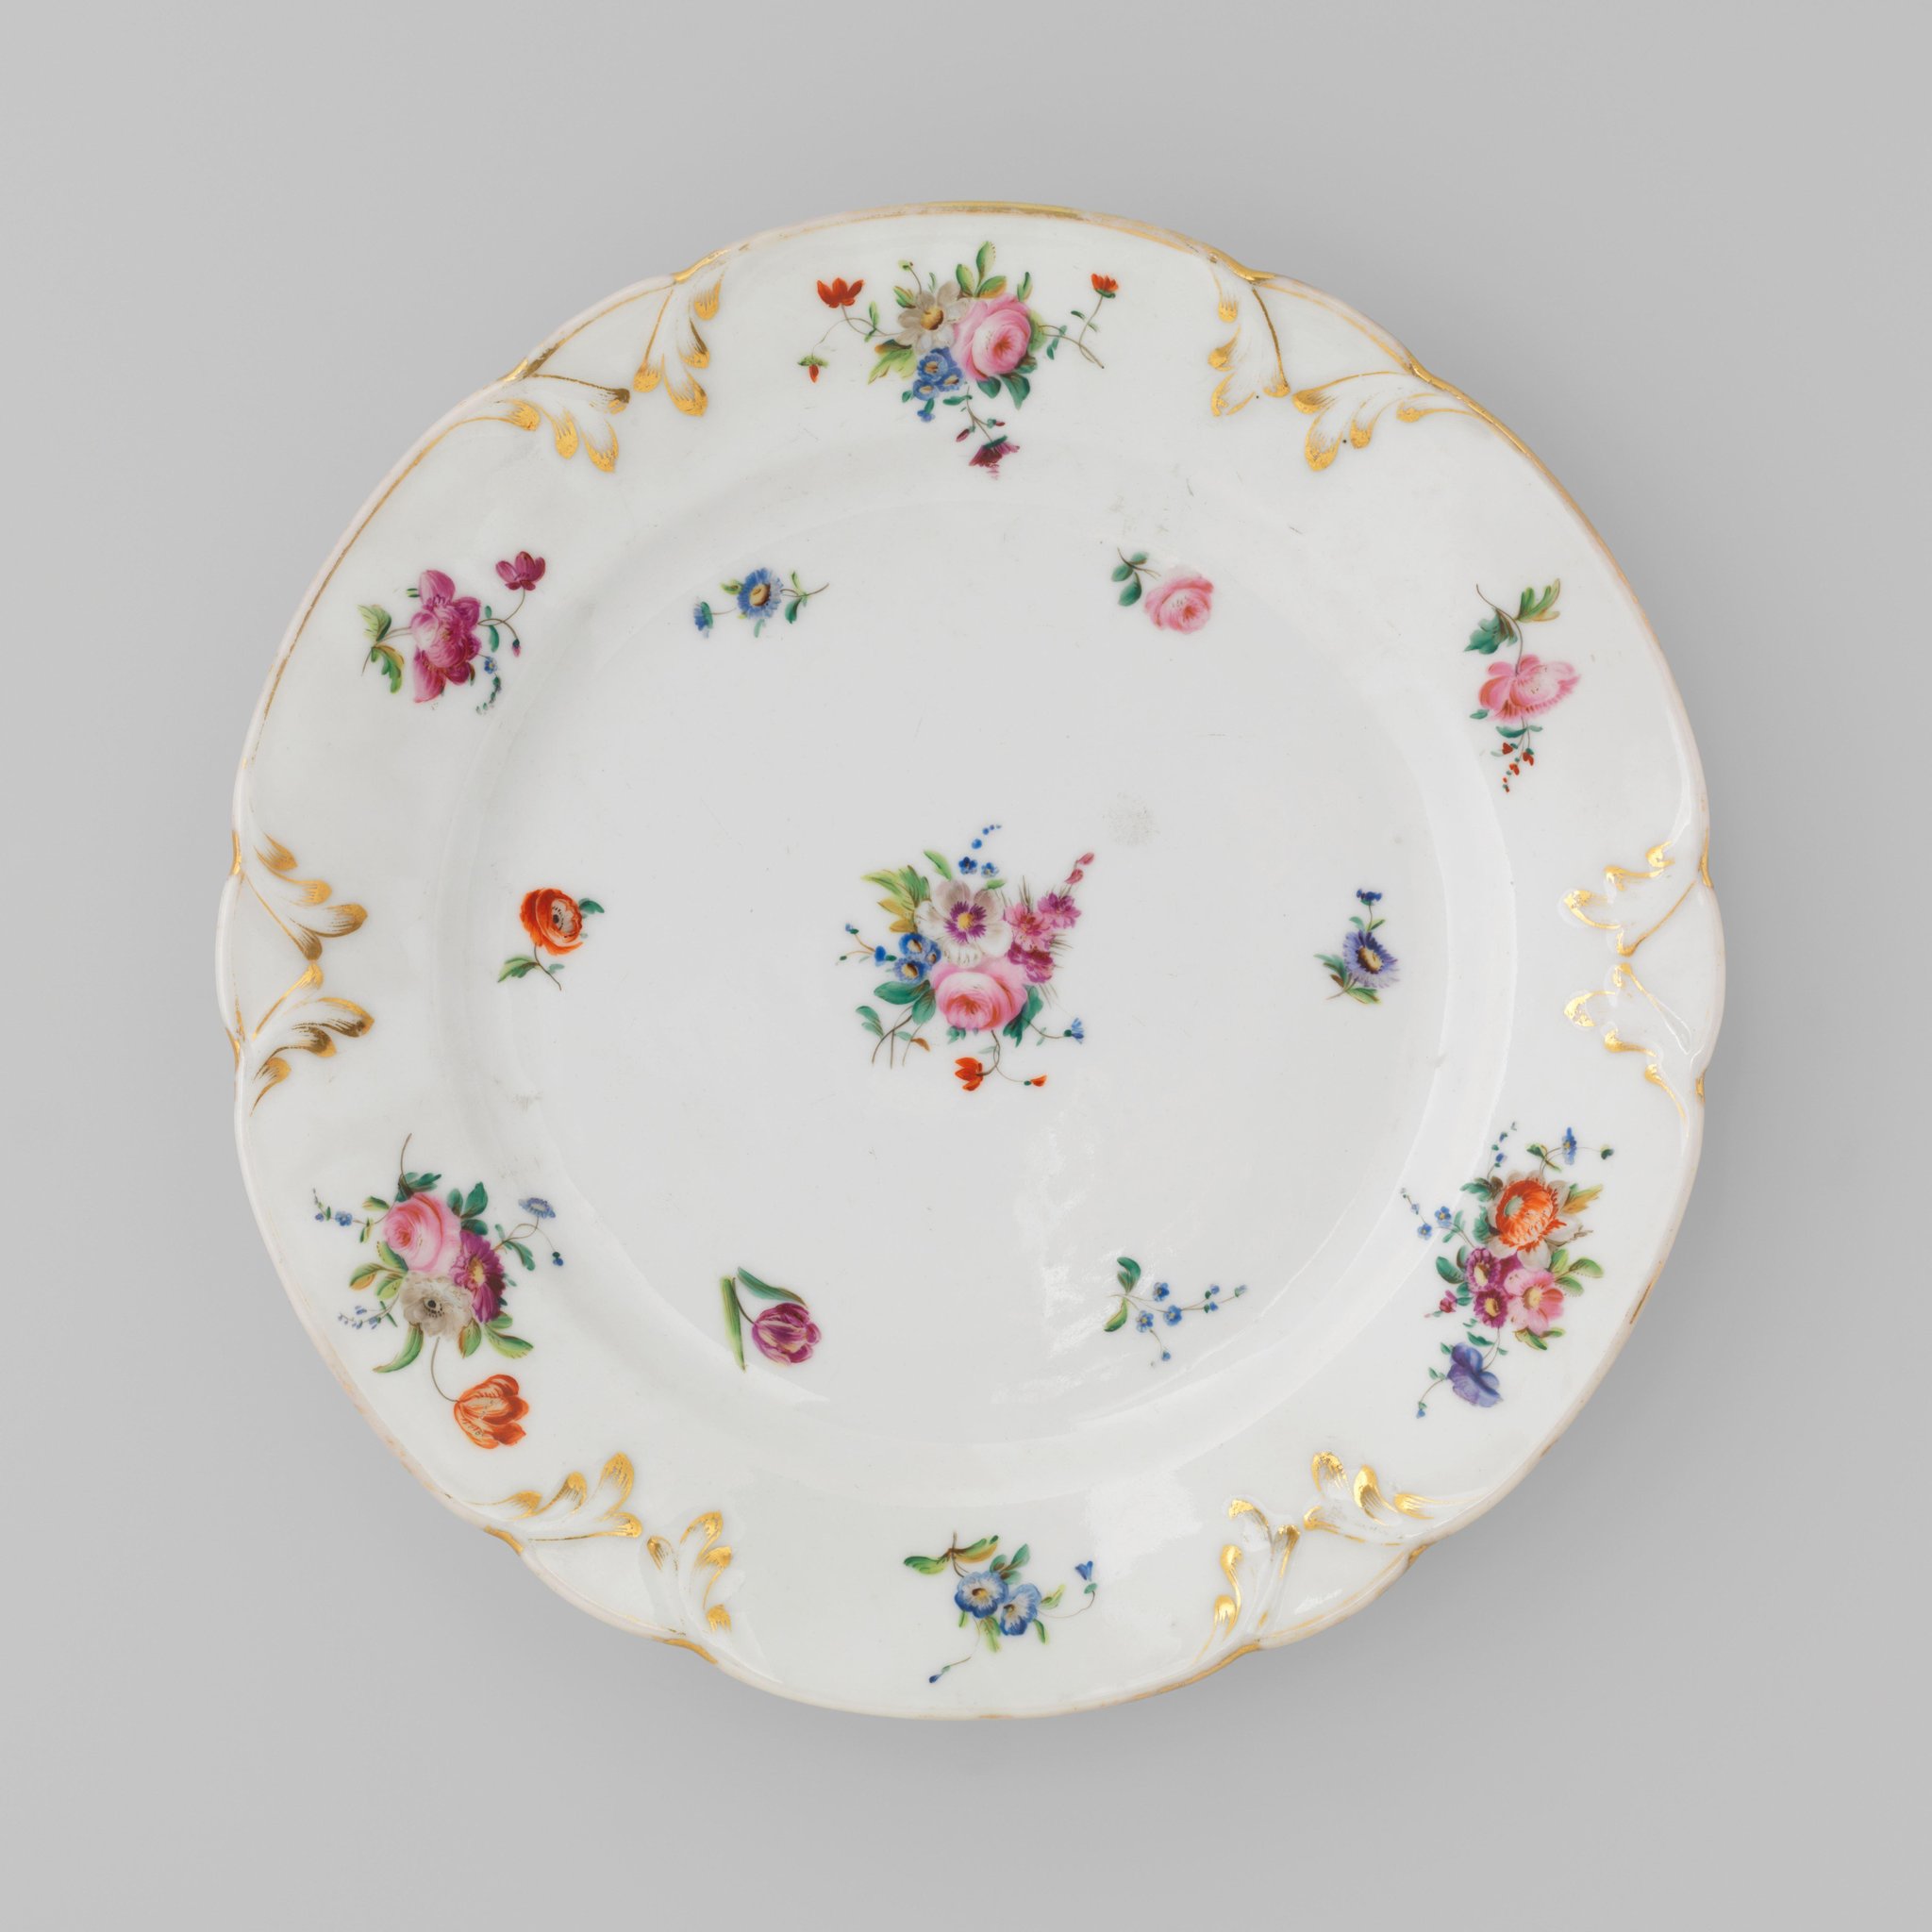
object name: service set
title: Plate with bouquets and flower sprays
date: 1839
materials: glaze, gold, paint, porcelain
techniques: firing, forming, gilding, turning, vitrification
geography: paris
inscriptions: mark: ‘DENUELLE/ Boulevard St. Denis 18/ à Paris’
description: Bord van porselein met een gelobde rand, beschilderd op het glazuur in blauw, rood, roze, groen, geel, paars, zwart en goud. Op het plat boeketten van verschillende bloemen en strooibloemen. Vanuit de gelobde, gouden rand, gemodelleerde bladranken in reliëf, aangezet met goud. Hiertussen boeketten. Drie proenen op de onderzijde. Gemerkt op de onderzijde met 'DENUELLE/ Boulevard St. Denis 18/ à Paris'.